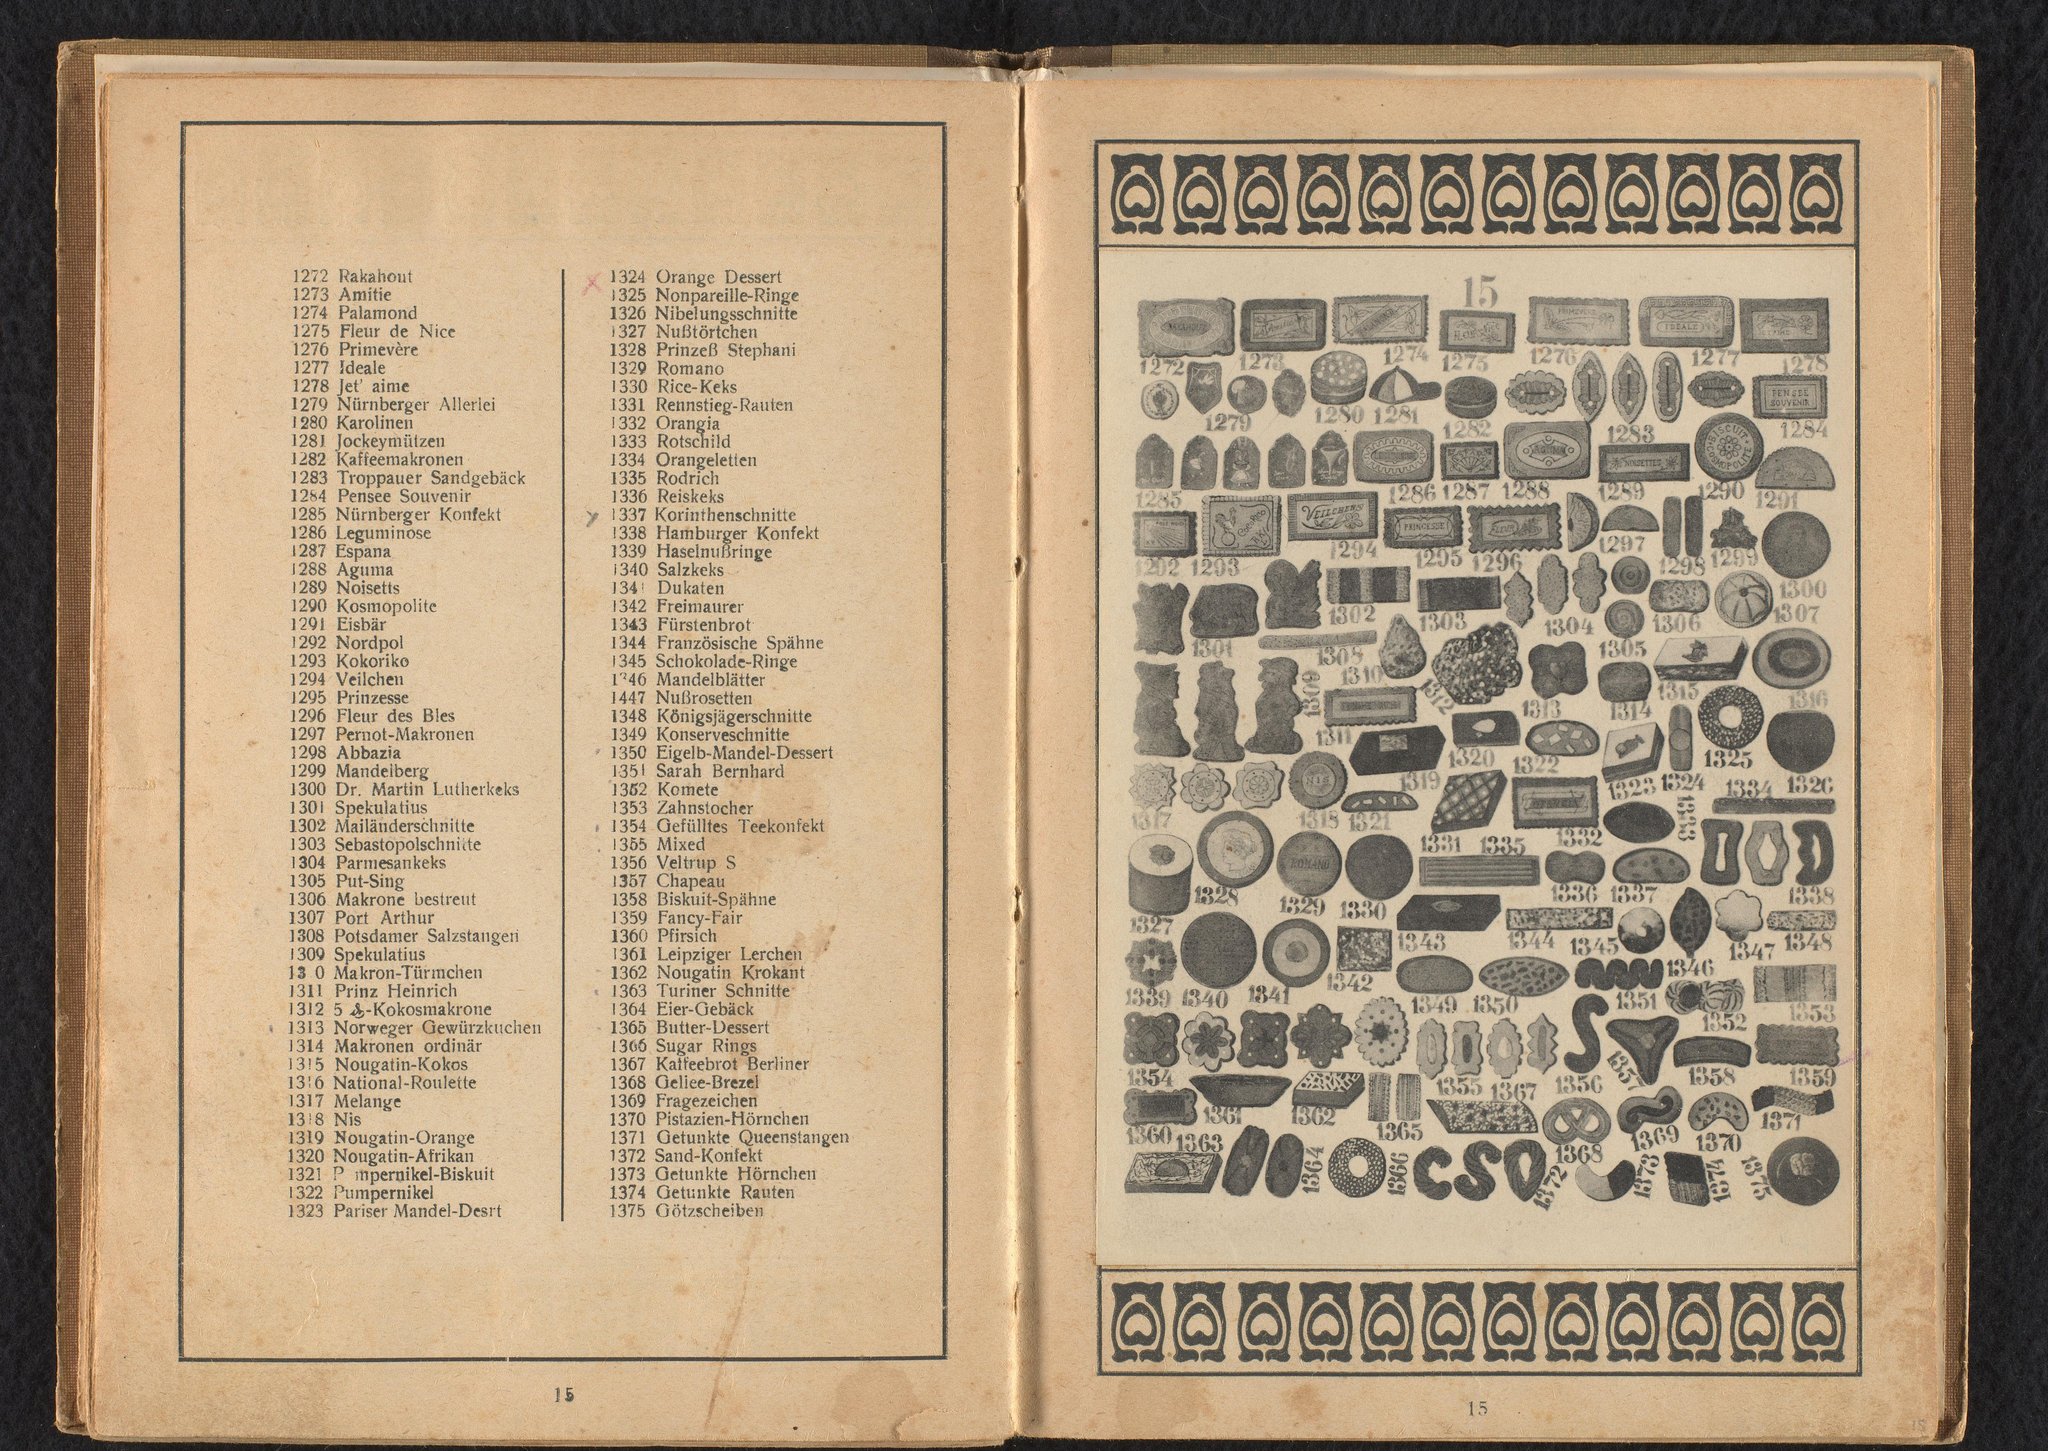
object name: page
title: Verschillende Engelse koekjes en biscuits als voorbeeld bij recepten 1272-1375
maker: Anonymous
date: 1900-1905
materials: paper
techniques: photograph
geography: bad langensalza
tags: pastry cook, moulds for biscuits, biscuits